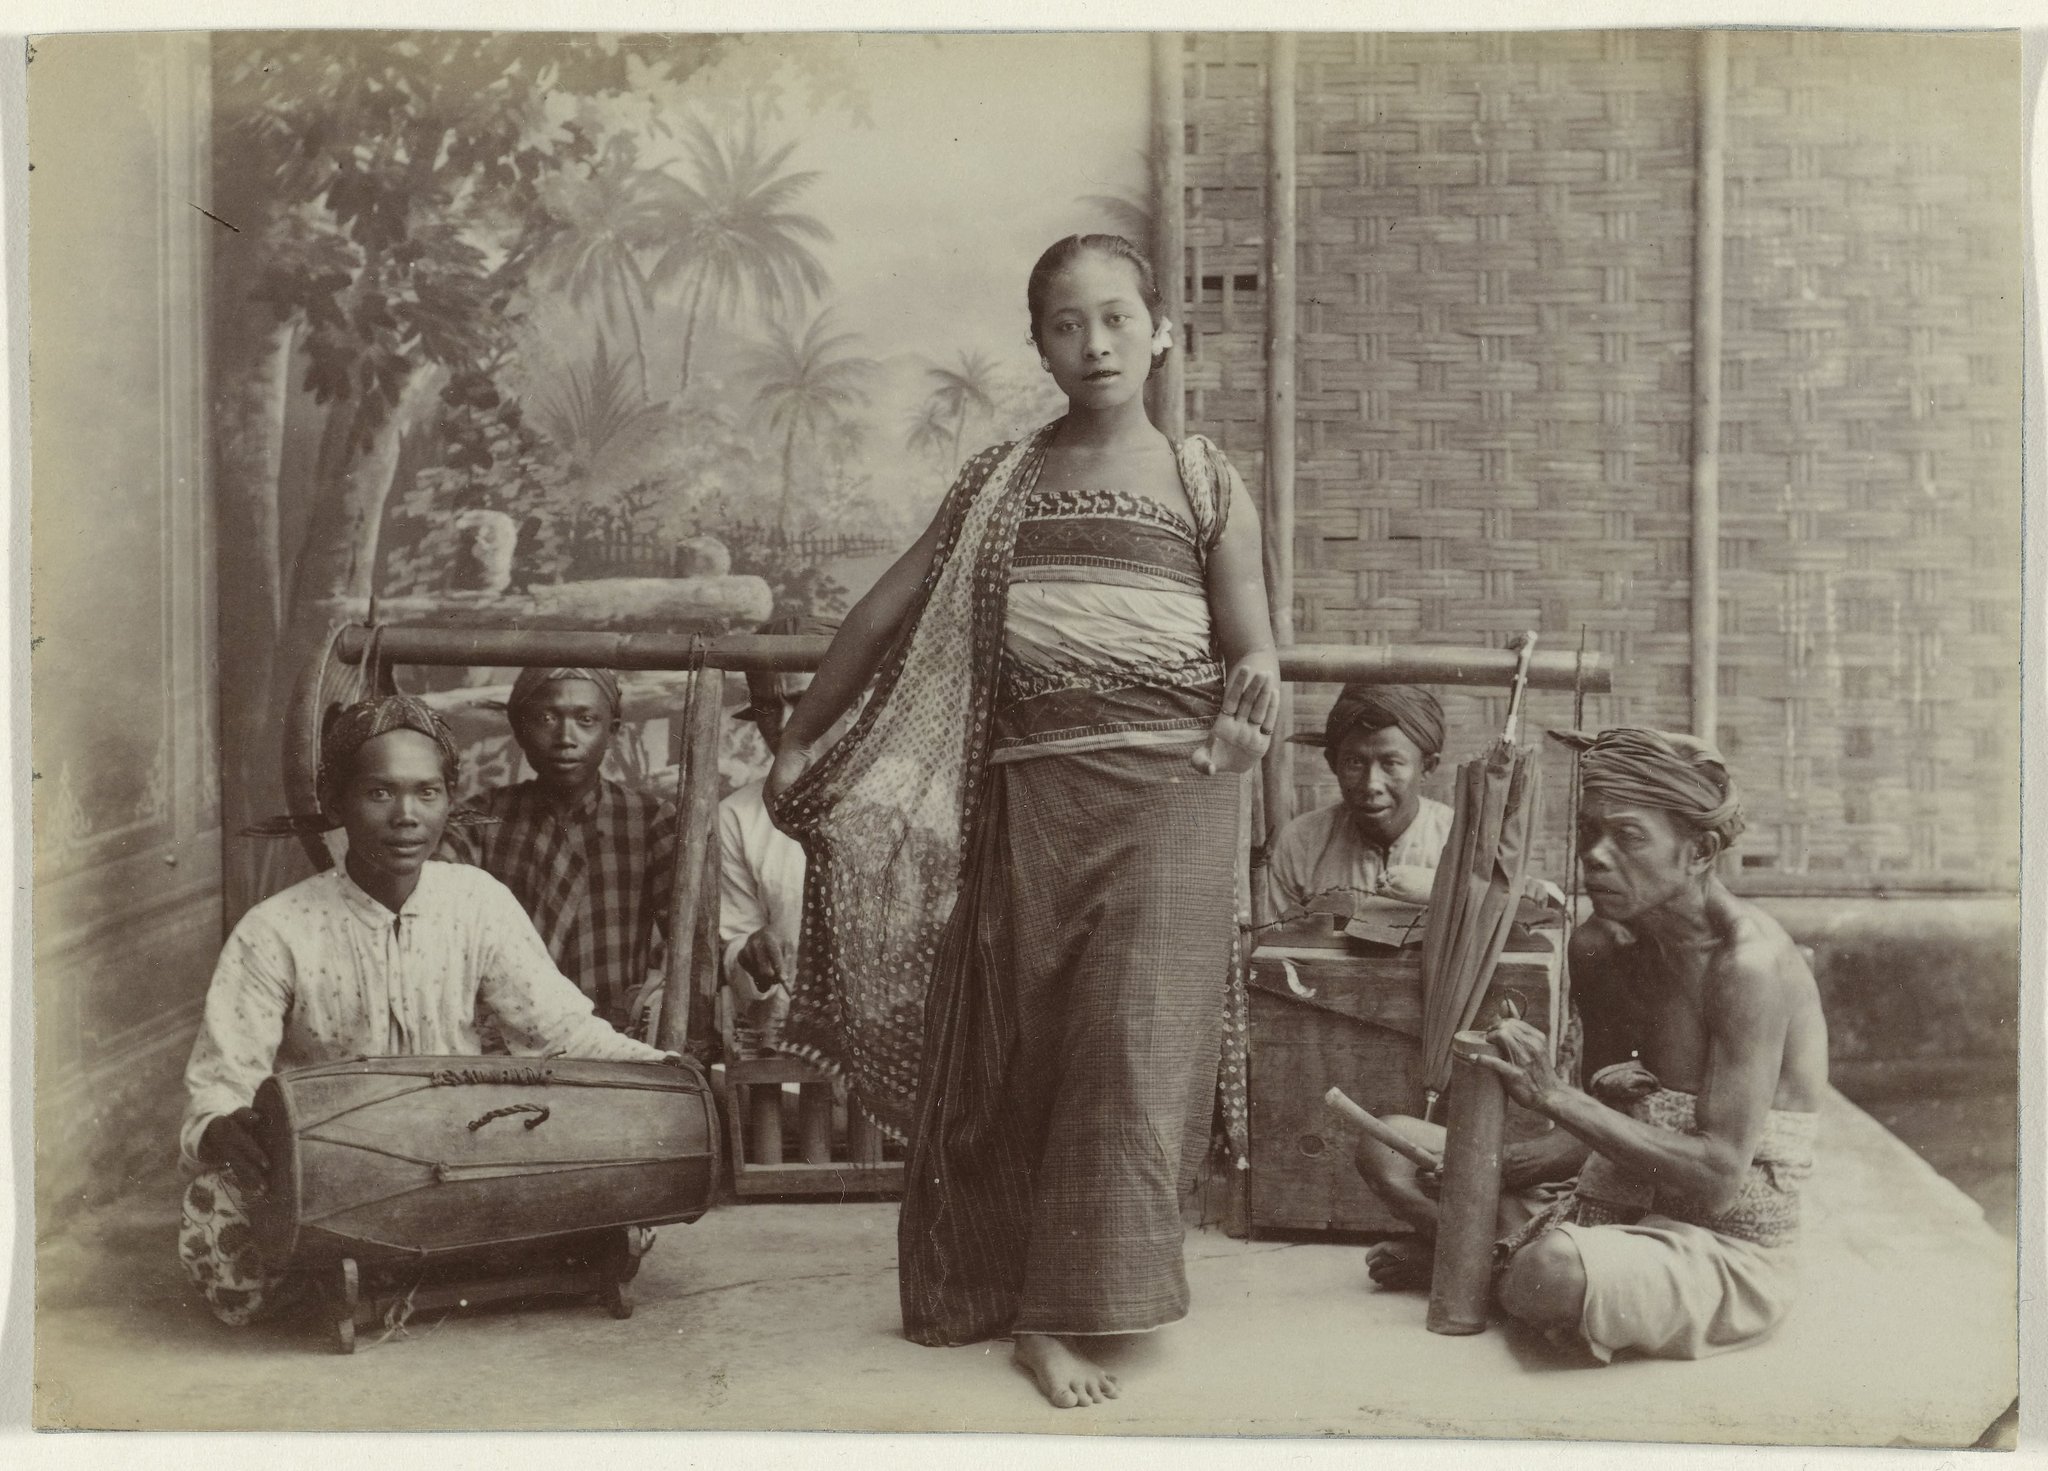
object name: photograph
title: Typen van Java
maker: kassian céphas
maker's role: fotograaf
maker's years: 1845-1912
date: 1880-1905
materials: paper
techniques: albumen print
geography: java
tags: anonymous historical person portrayed, female dancer, more than one musician with instrument, java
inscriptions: inscription: ‘Typen van/ Java’